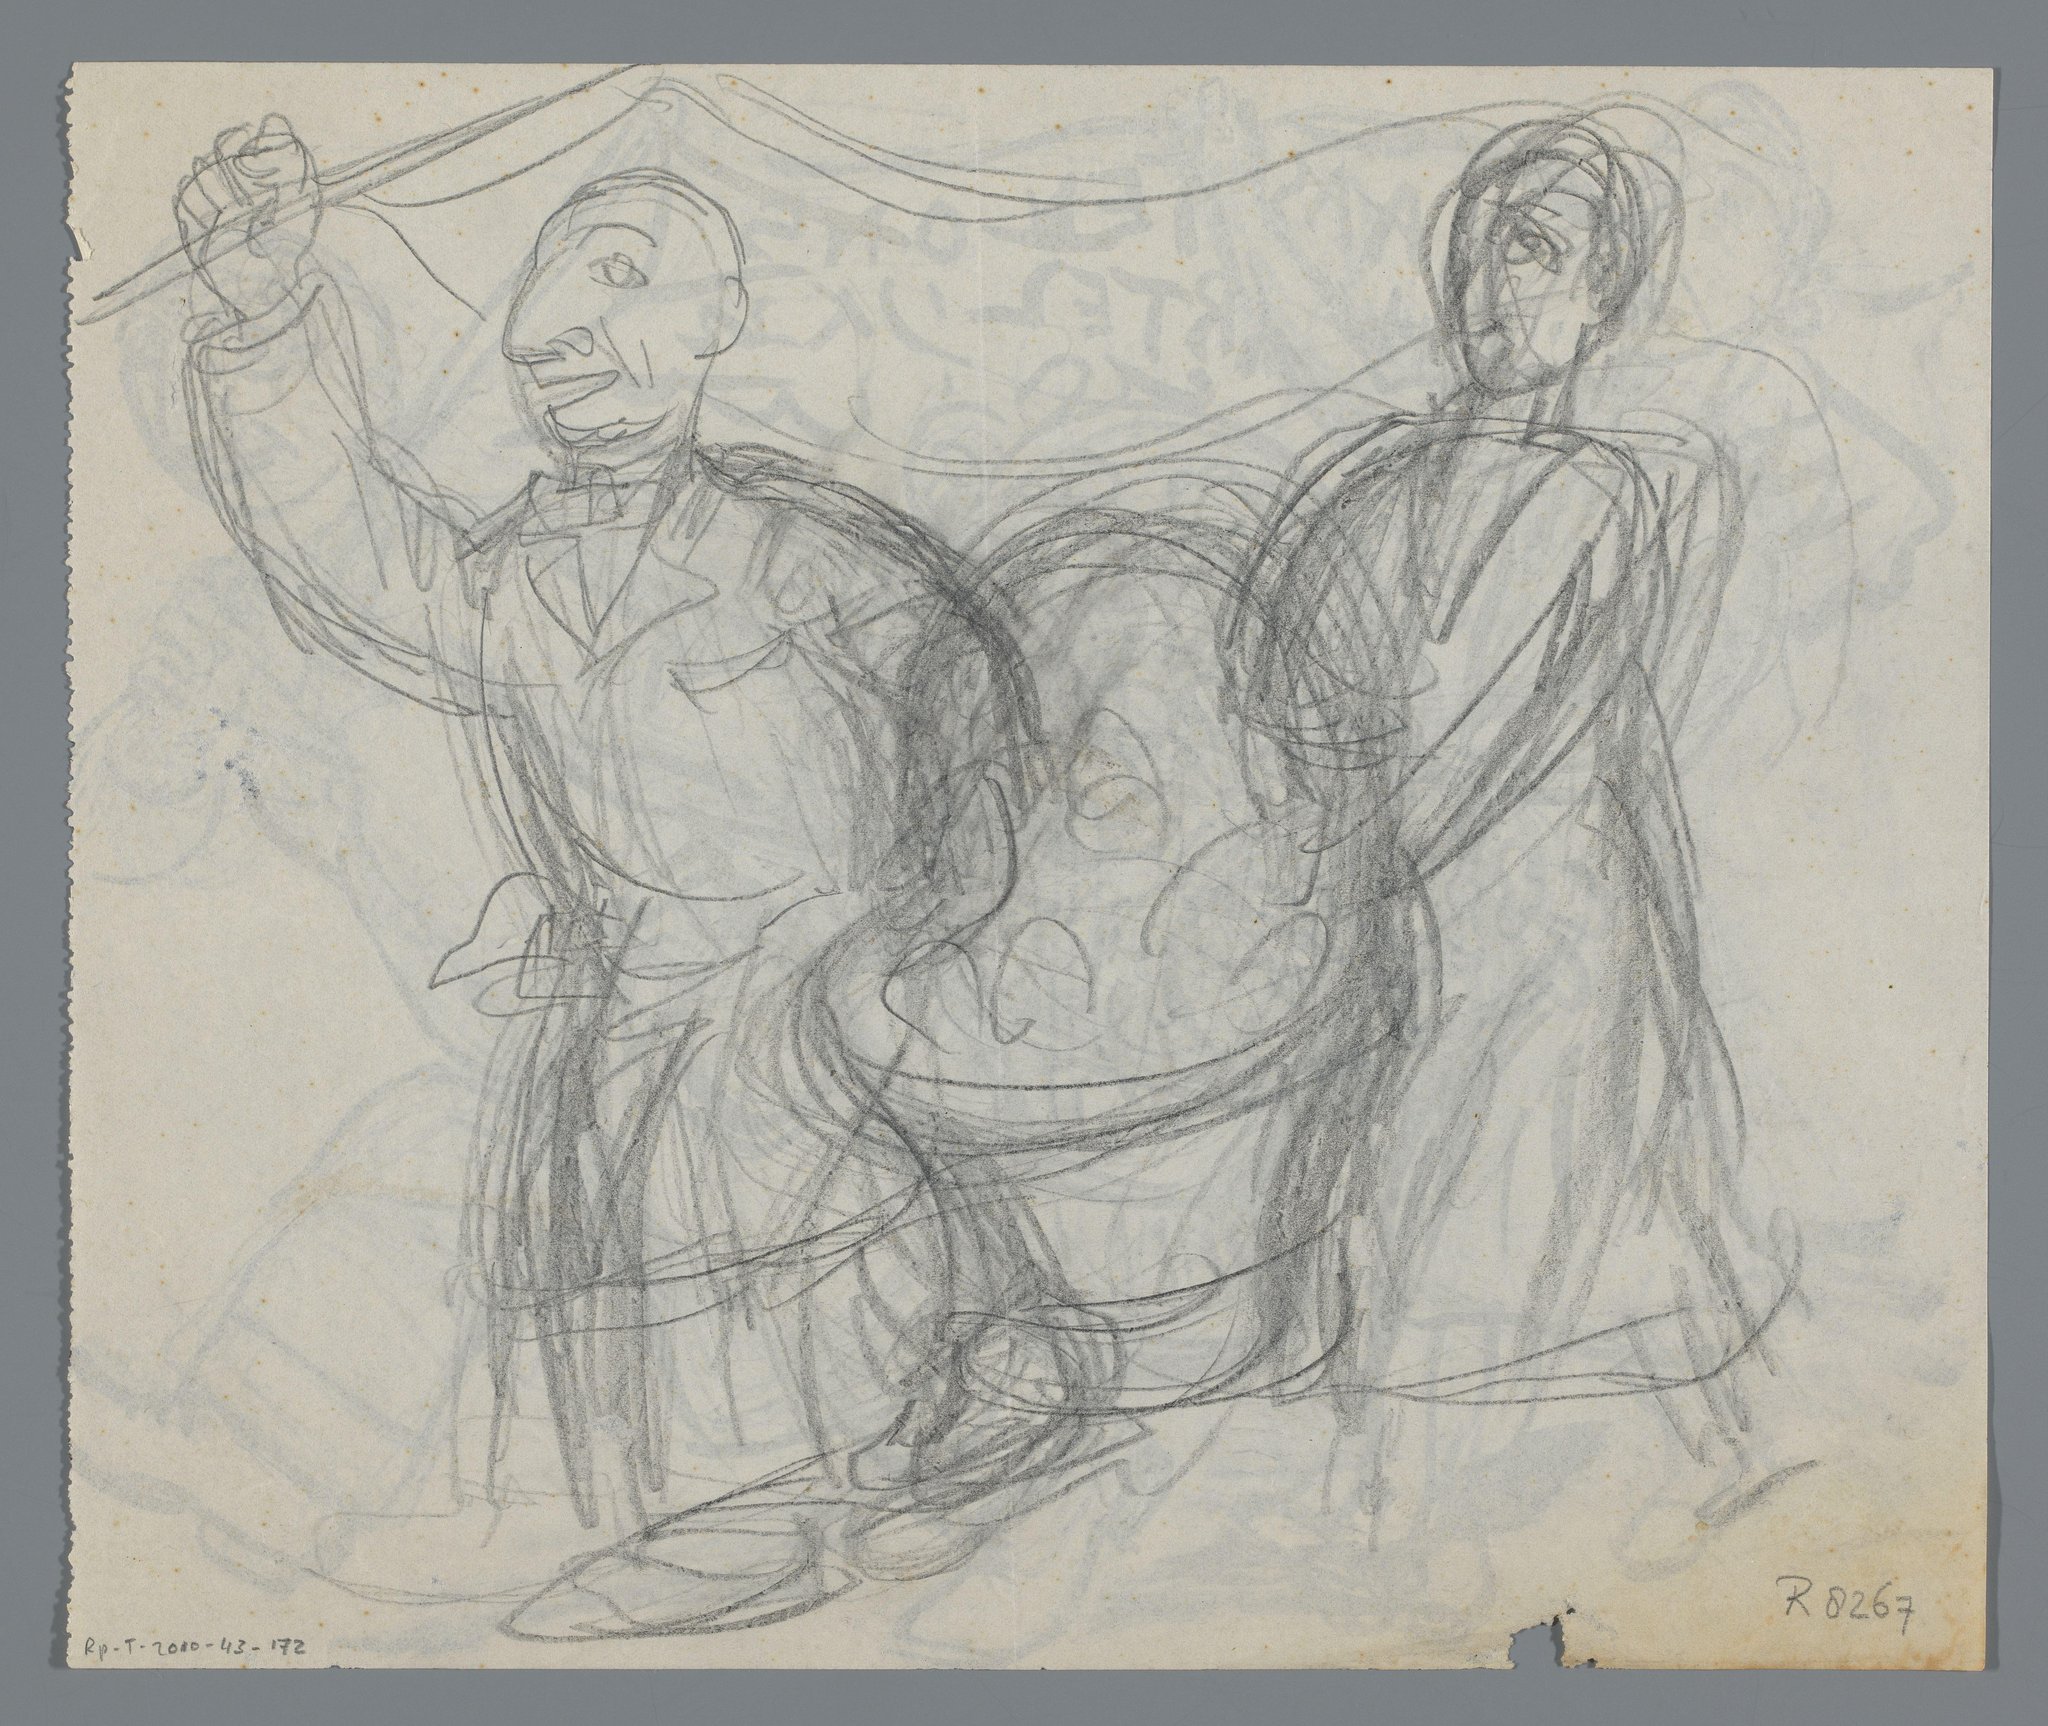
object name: drawing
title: Leo Gestel en An Overtoom met bloemstuk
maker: leo gestel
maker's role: draughtsman, print maker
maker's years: 1881-1941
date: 1937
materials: paper, pencil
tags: print maker, draughtsman, leo gestel, amsterdam, painter, gerritje gestel-overtoom, flowers, adult woman, adult man